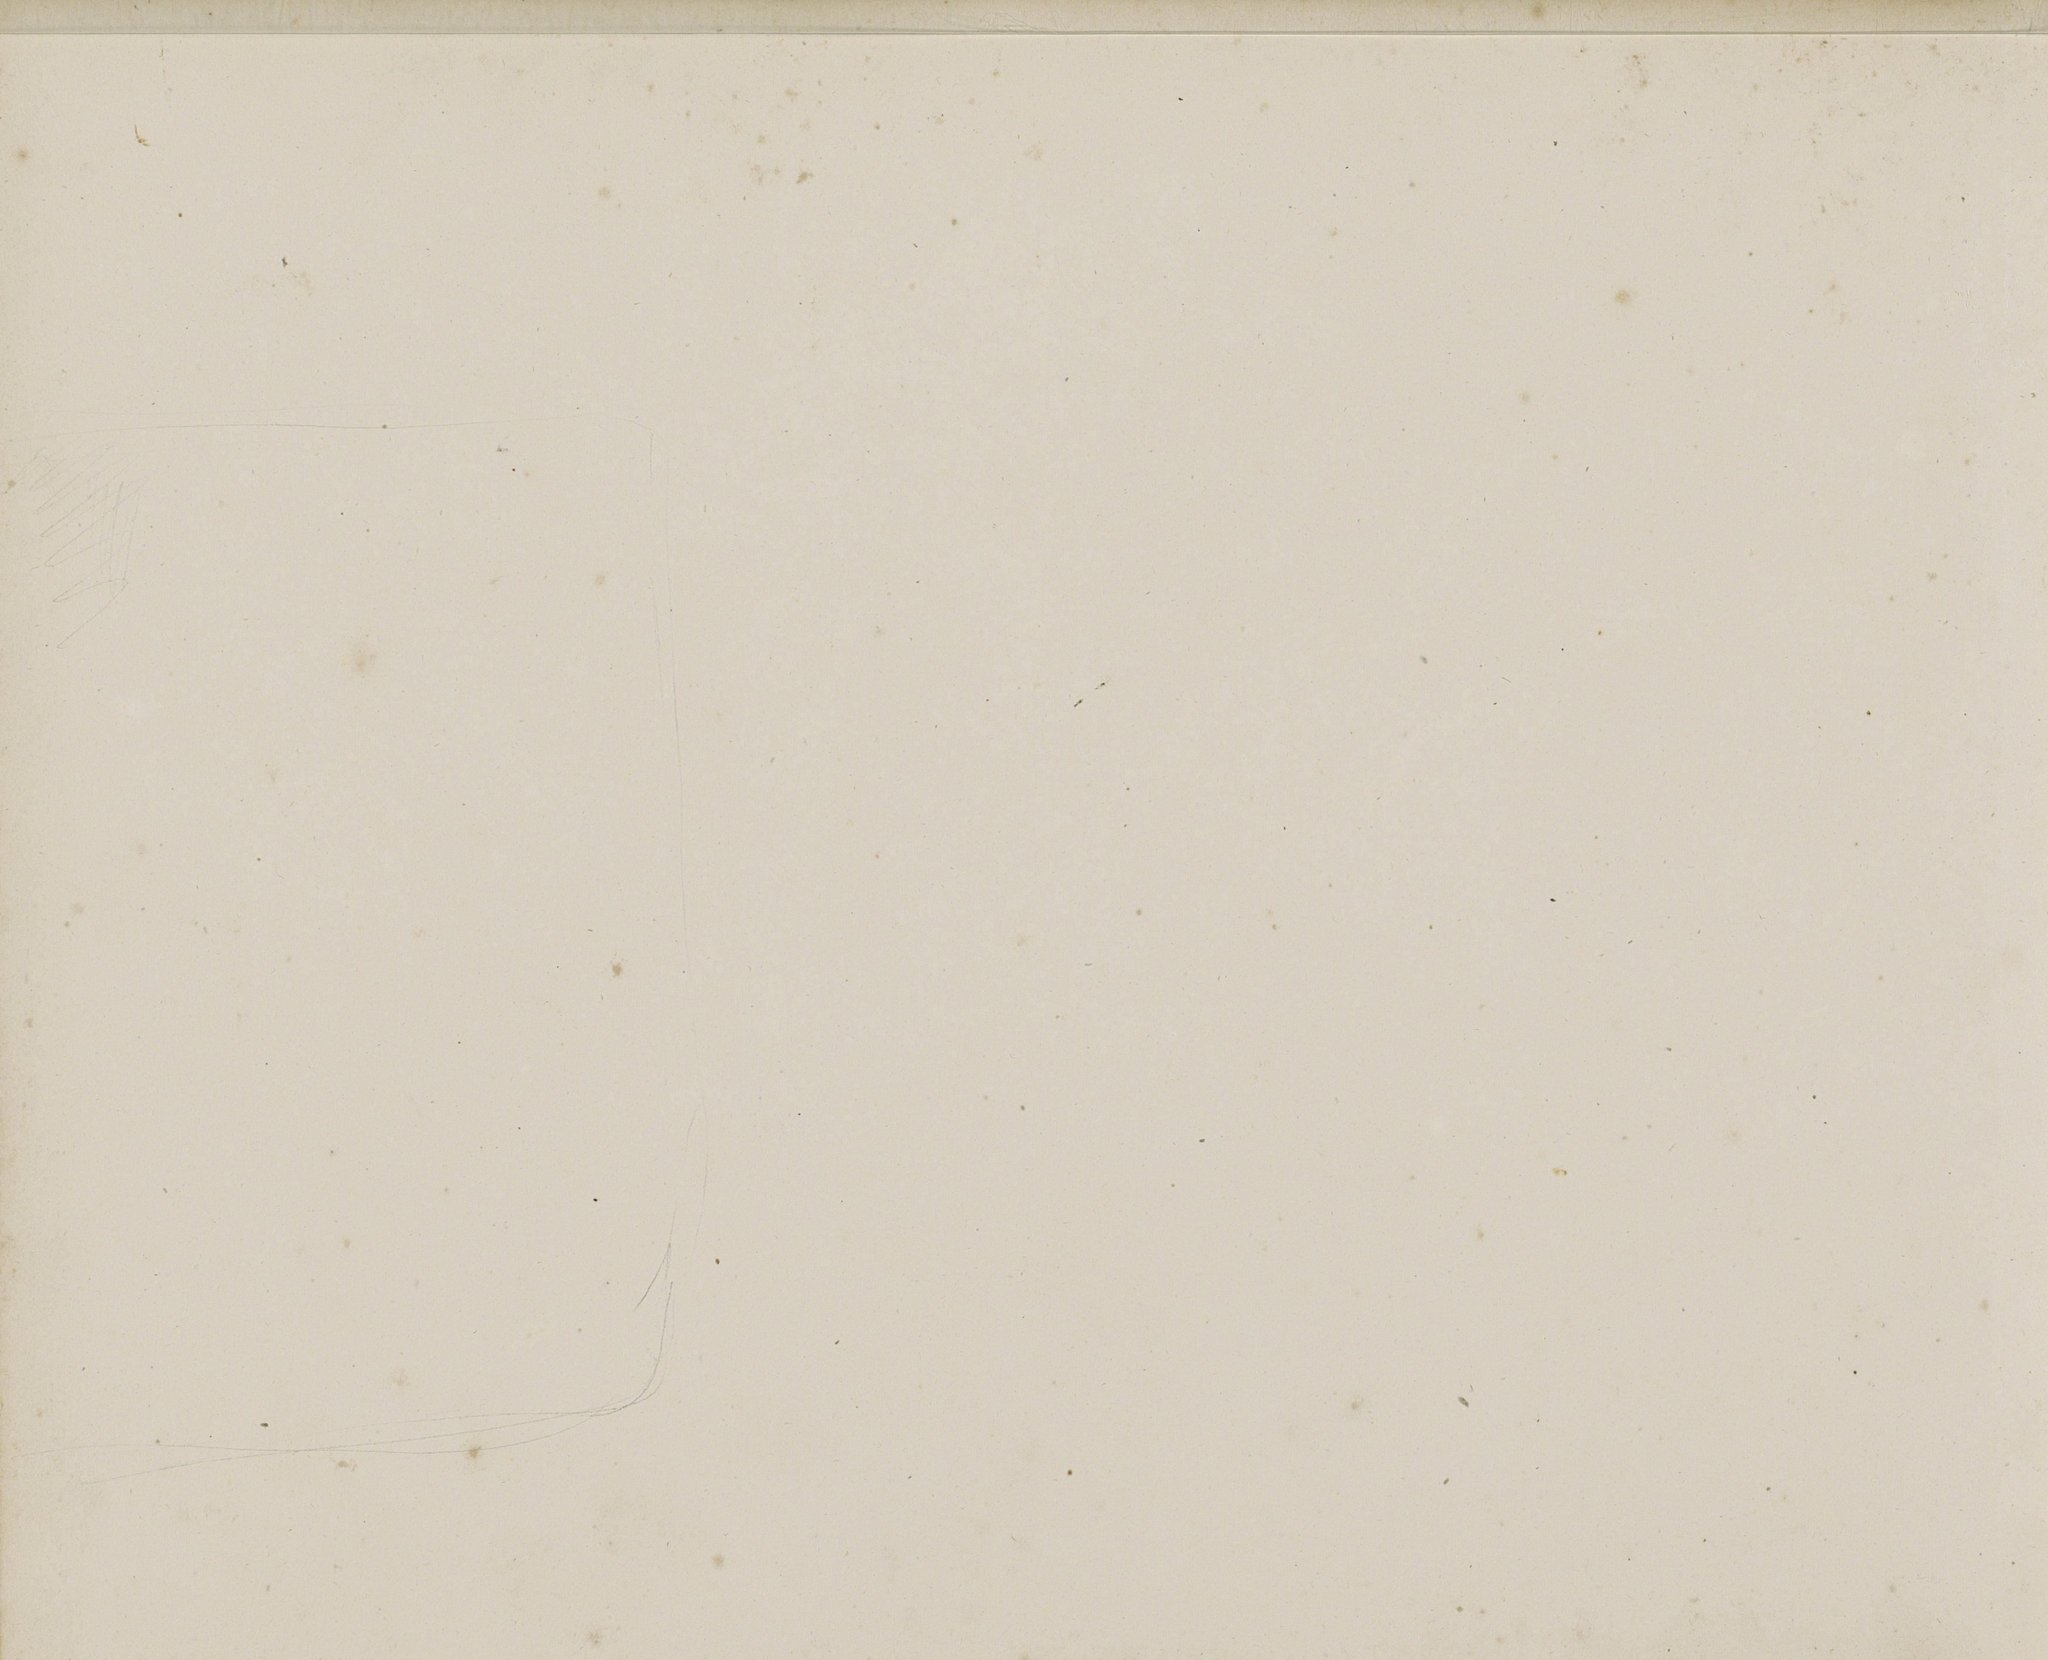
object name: sketchbook leaf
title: Studie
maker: gerrit postma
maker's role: draughtsman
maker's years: 1819-1894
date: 1829-1894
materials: paper, pencil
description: Blad 18 verso uit een schetsboek met 35 bladen.